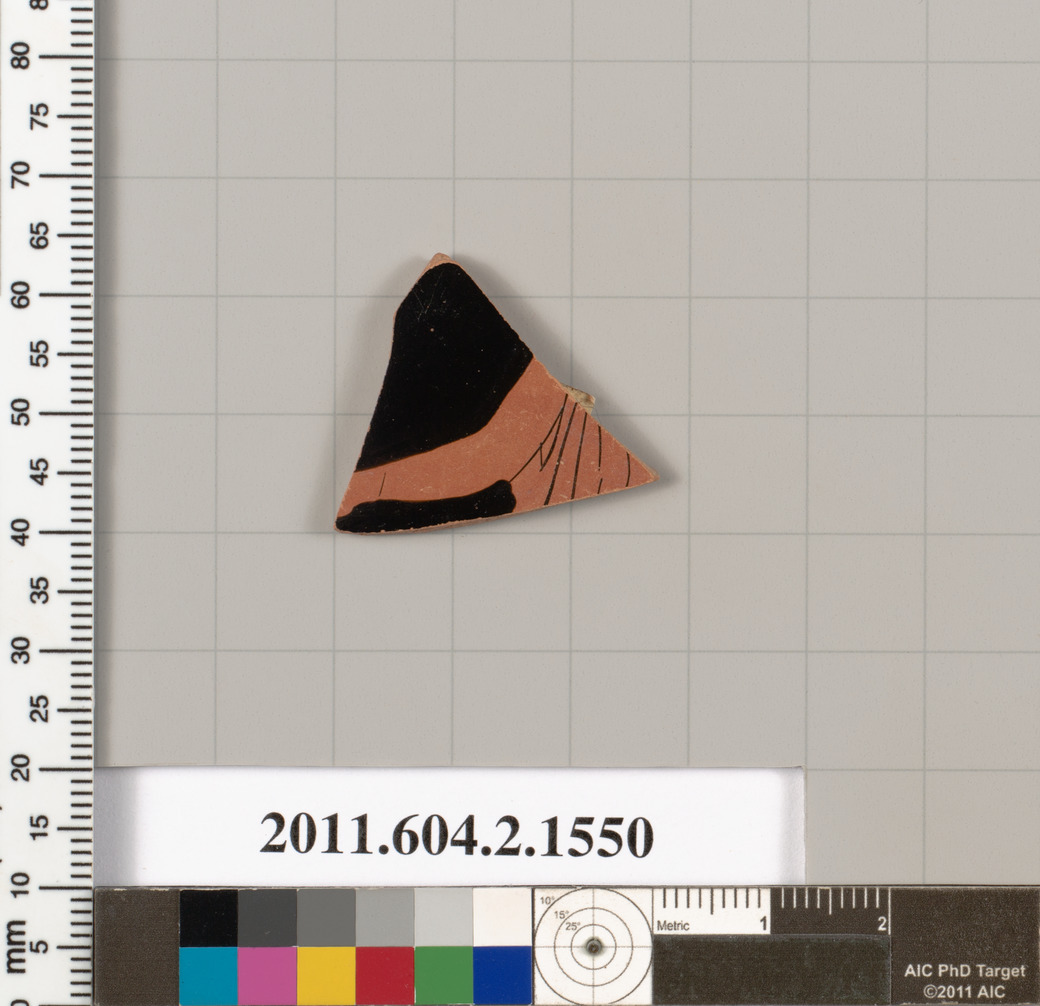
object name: skyphos fragment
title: Terracotta fragment of a skyphos (deep drinking cup)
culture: greek, attic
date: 450-426 BCE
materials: terracotta